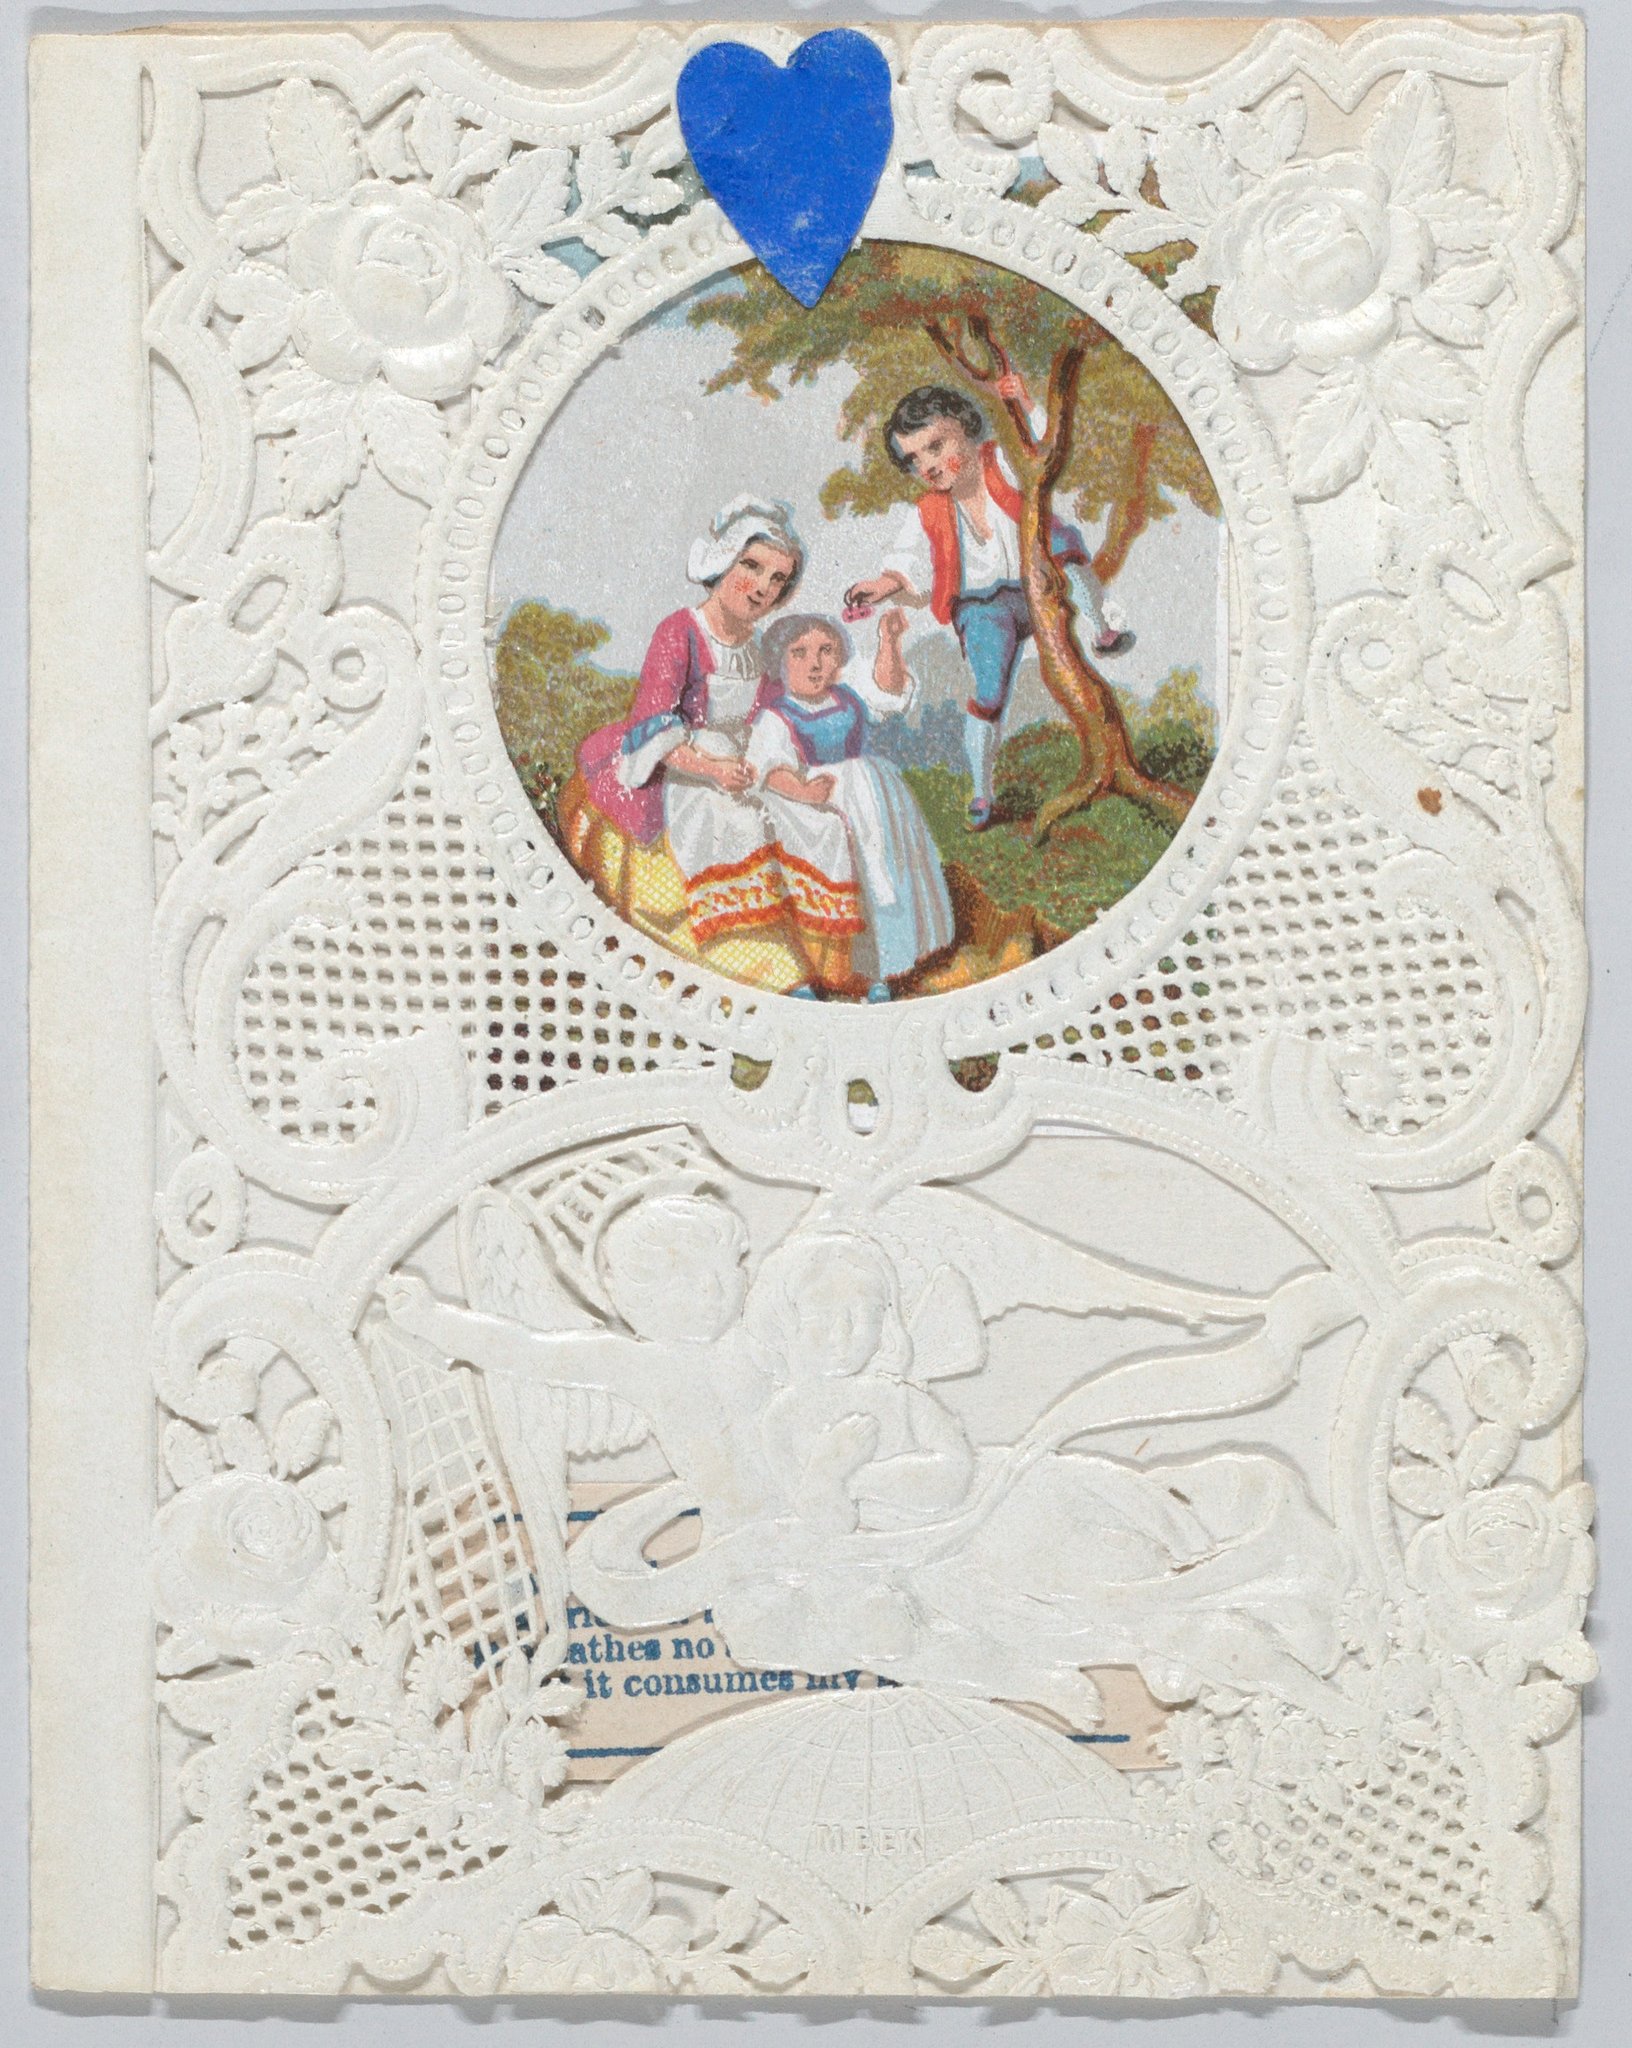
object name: valentine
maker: Anonymous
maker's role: artist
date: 1847-1870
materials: lace, paper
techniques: chromolithography, embossing, open work